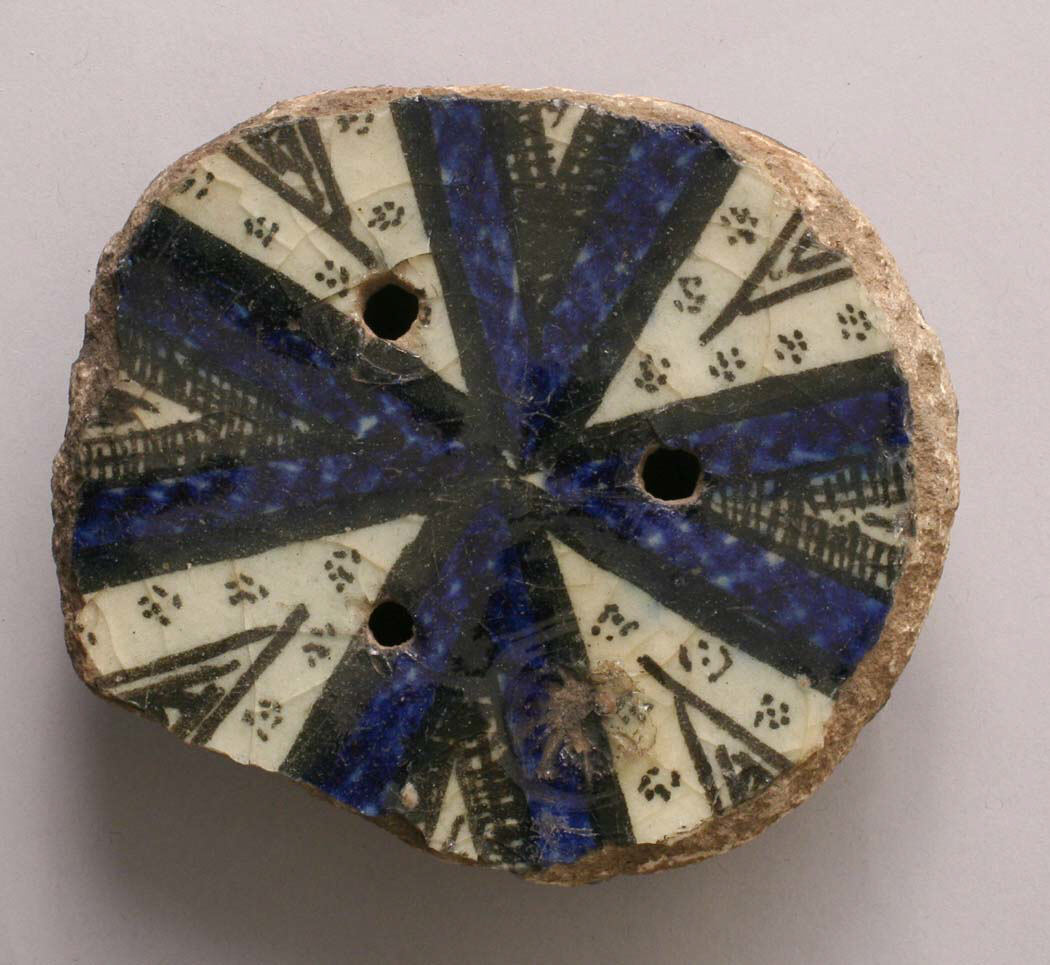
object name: ceramic fragment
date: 1301-1400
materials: glaze, stonepaste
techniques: painting, polychrome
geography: syria